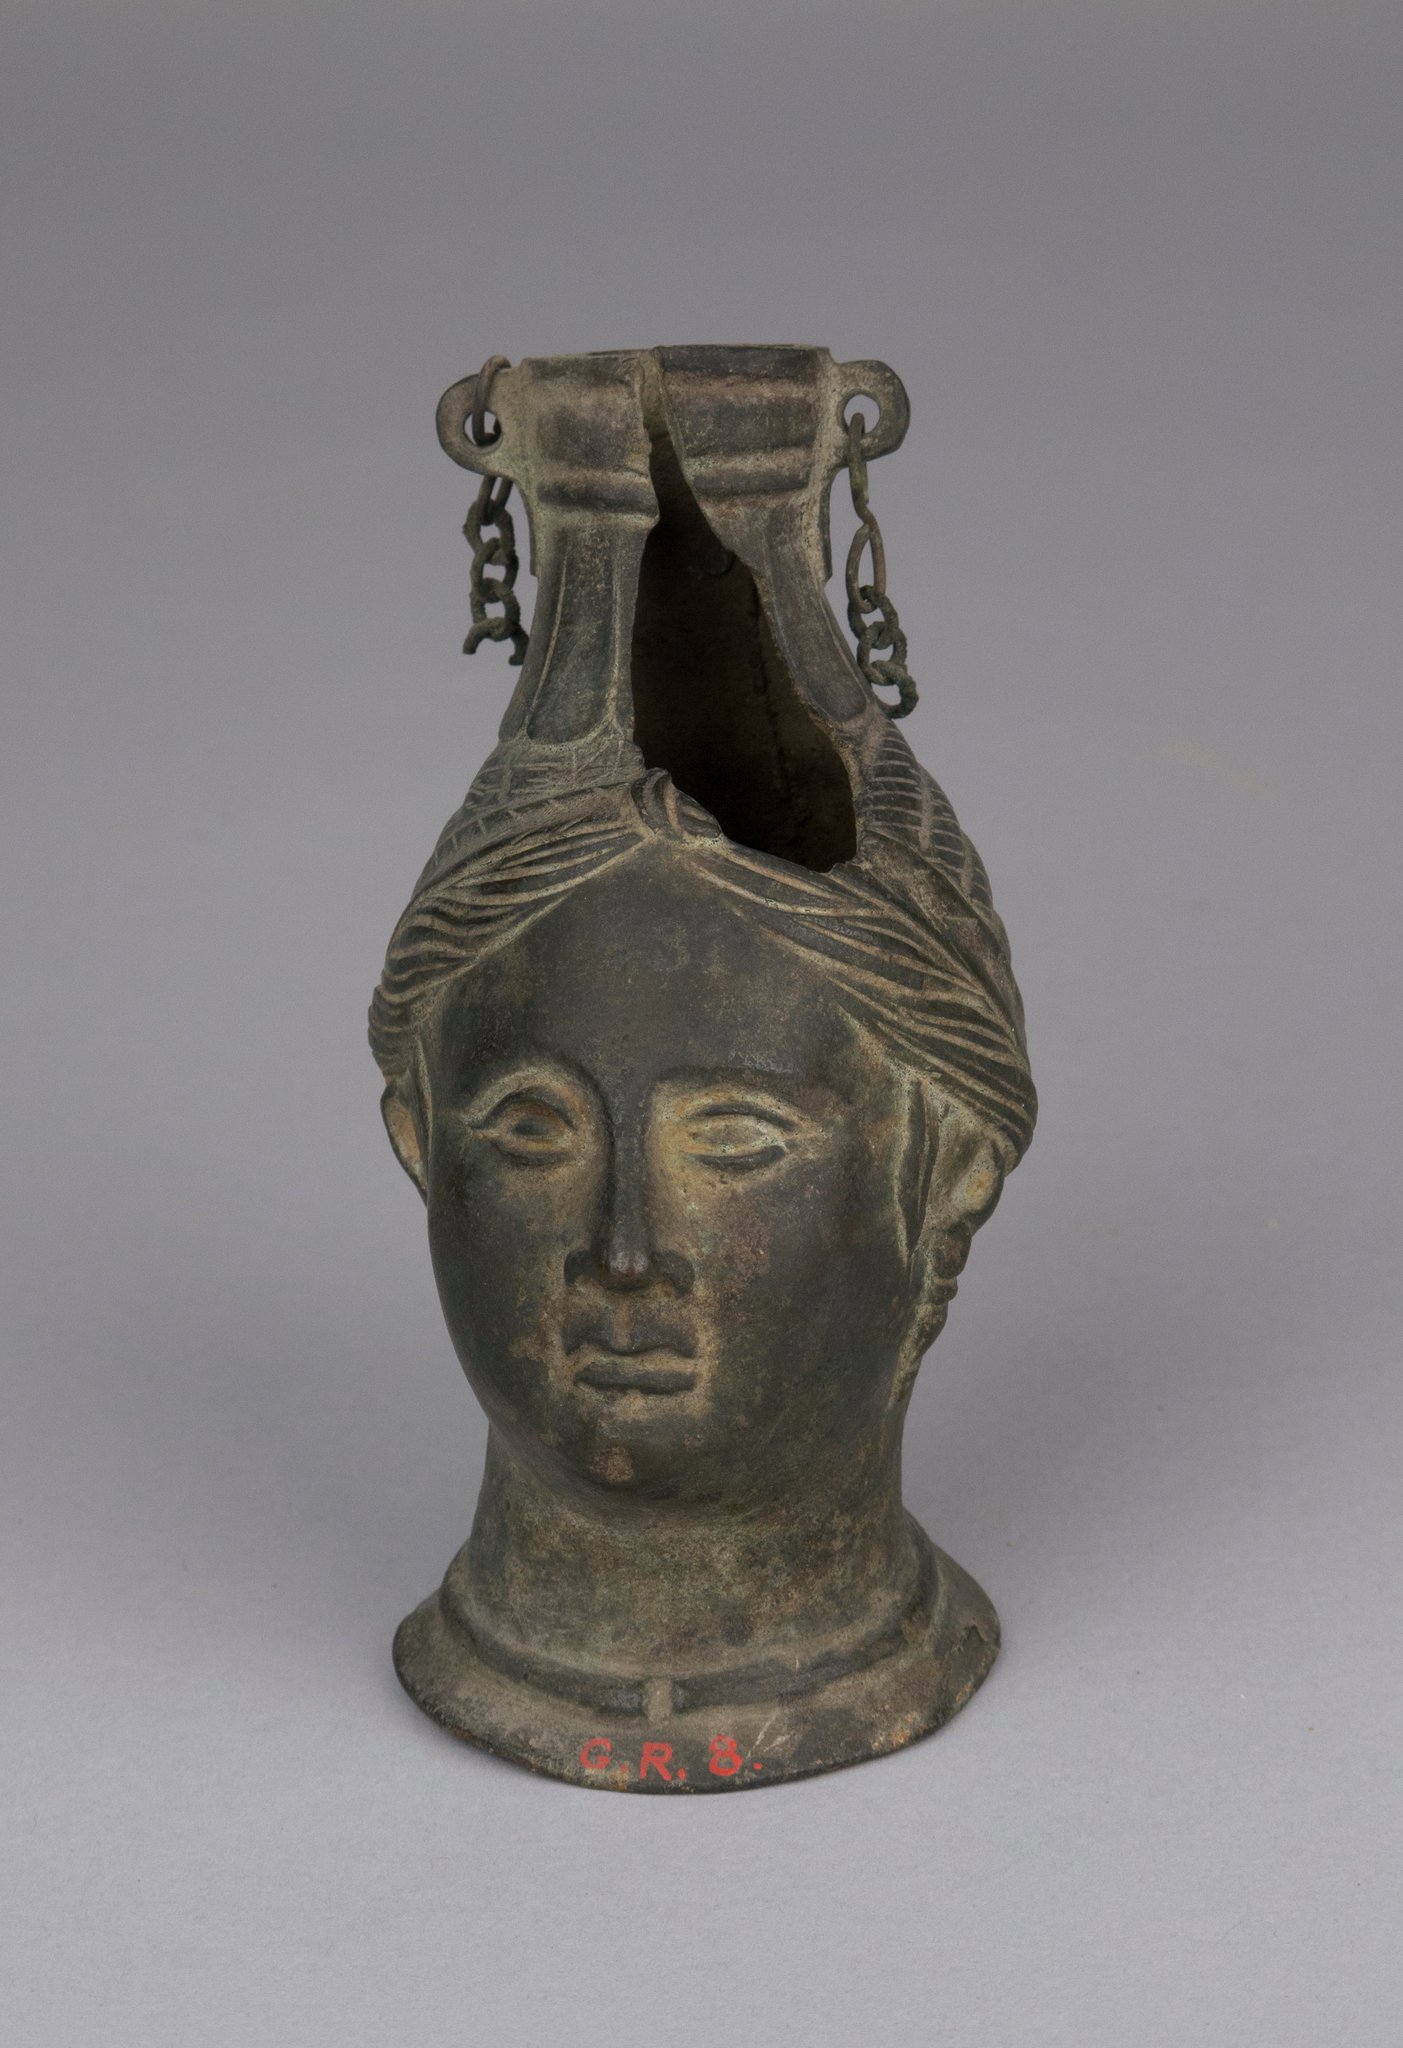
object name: rhyton in the form of a female head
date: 7000 BCE-330 CE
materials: bronze